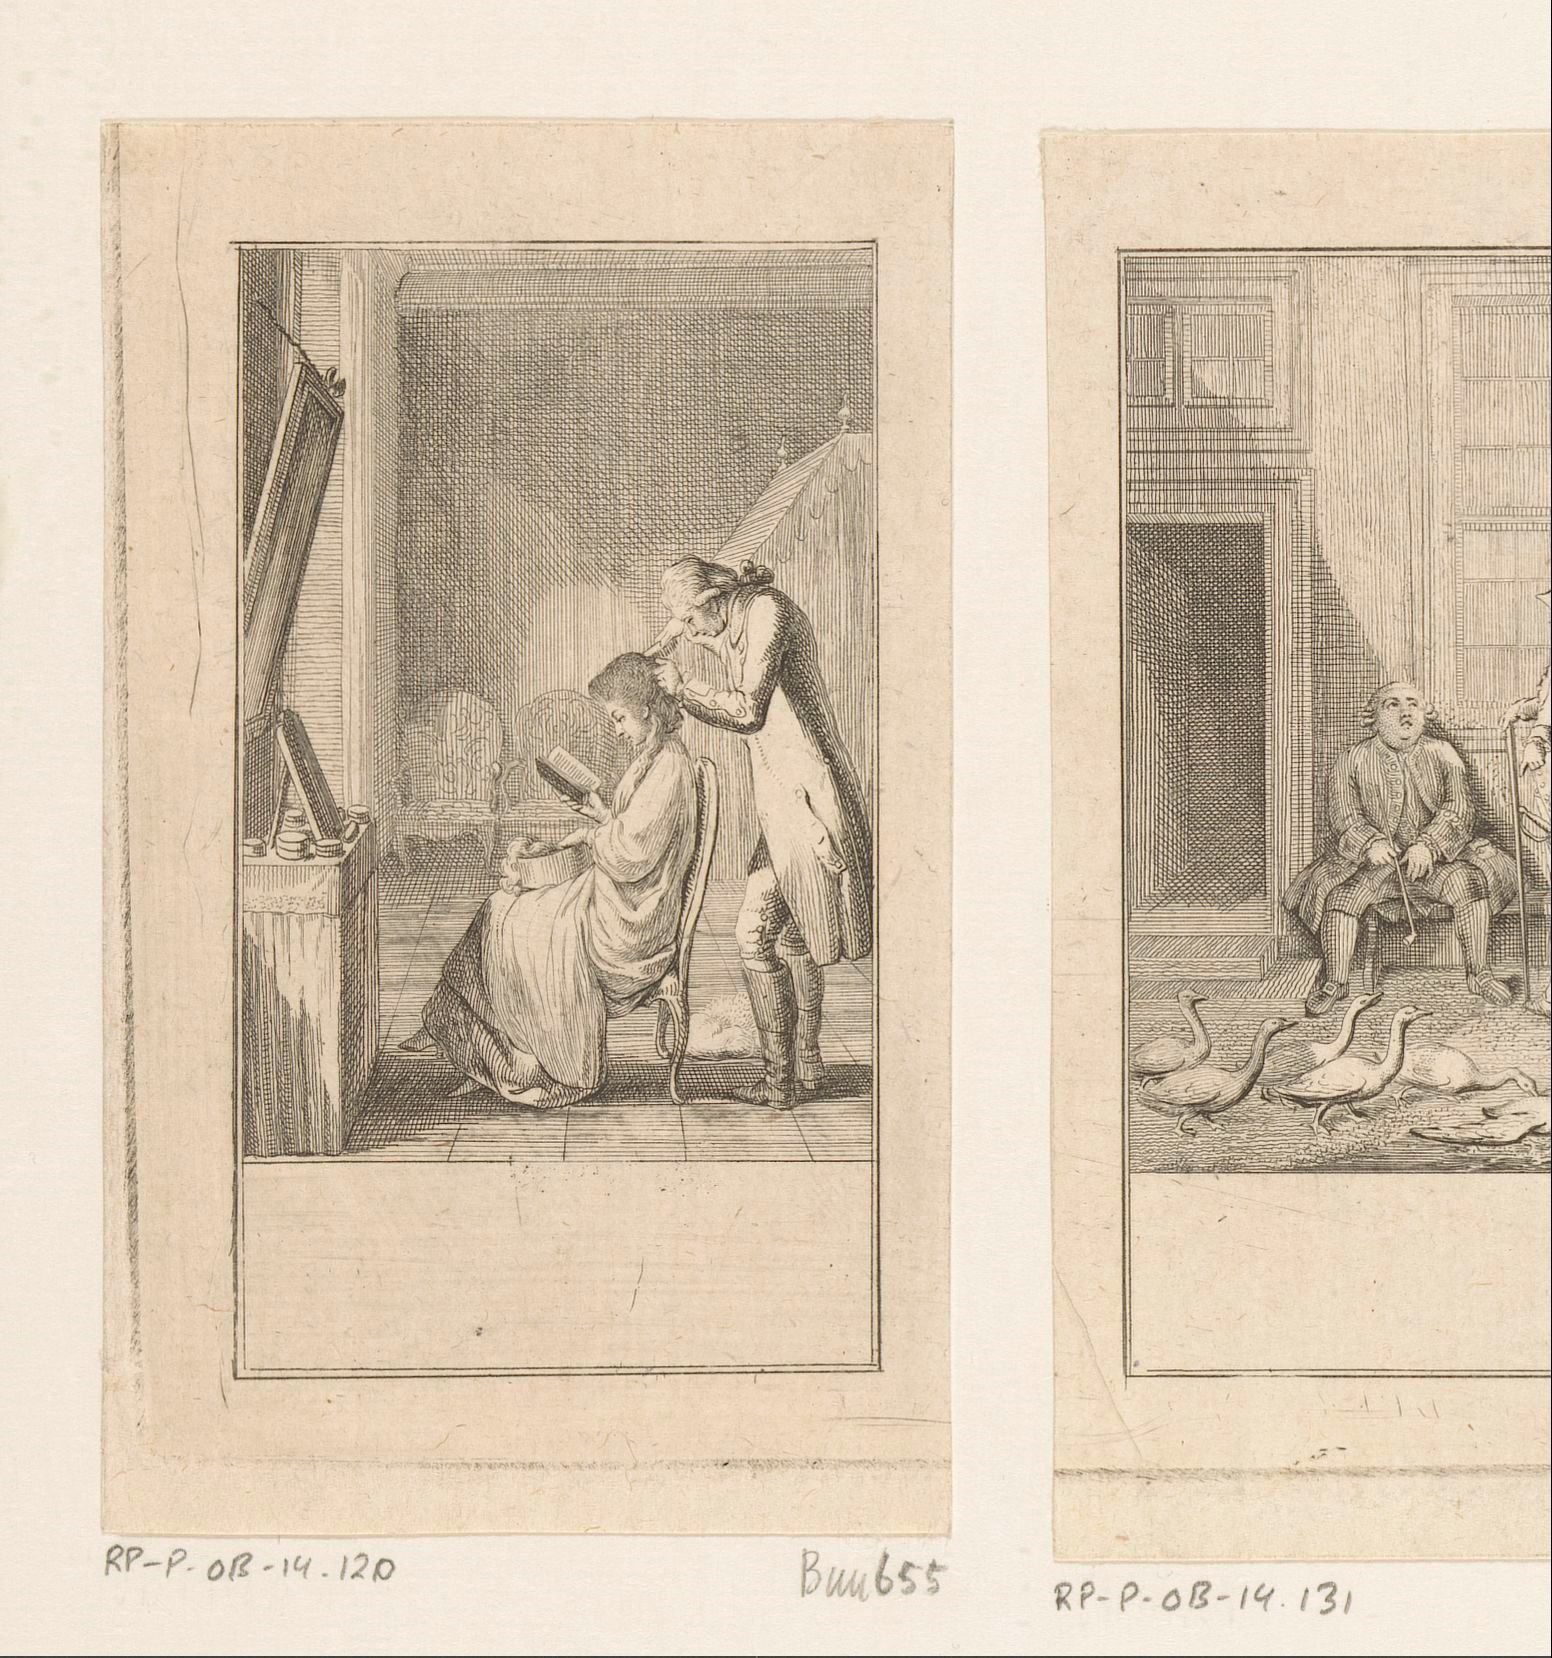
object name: print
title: Jonge vrouw leest een boek bij de kapper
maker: daniel nikolaus chodowiecki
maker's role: draughtsman, print maker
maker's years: 1726-1801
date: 1779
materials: paper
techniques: etching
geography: berlin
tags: reading, book - mm - book open, hairdresser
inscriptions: collector's mark: Lugt 2228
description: Zevende prent afkomstig uit een serie van twaalf verschillende prenten. Deze serie is een herhaling van dezelfde serie met onderschriften in het Duits (zie: RP-P-OB-14.106). De scènes zijn op een plaat geëtst. Deze staat niet beschreven in Engelmann: met uitwerking van de lucht en schaduwpartijen maar voor toevoeging van nummers en onderschriften. Een latere staat van deze serie is ook gebruikt in: Almanac genealogique de Lauenbourg pour l'année 1780.